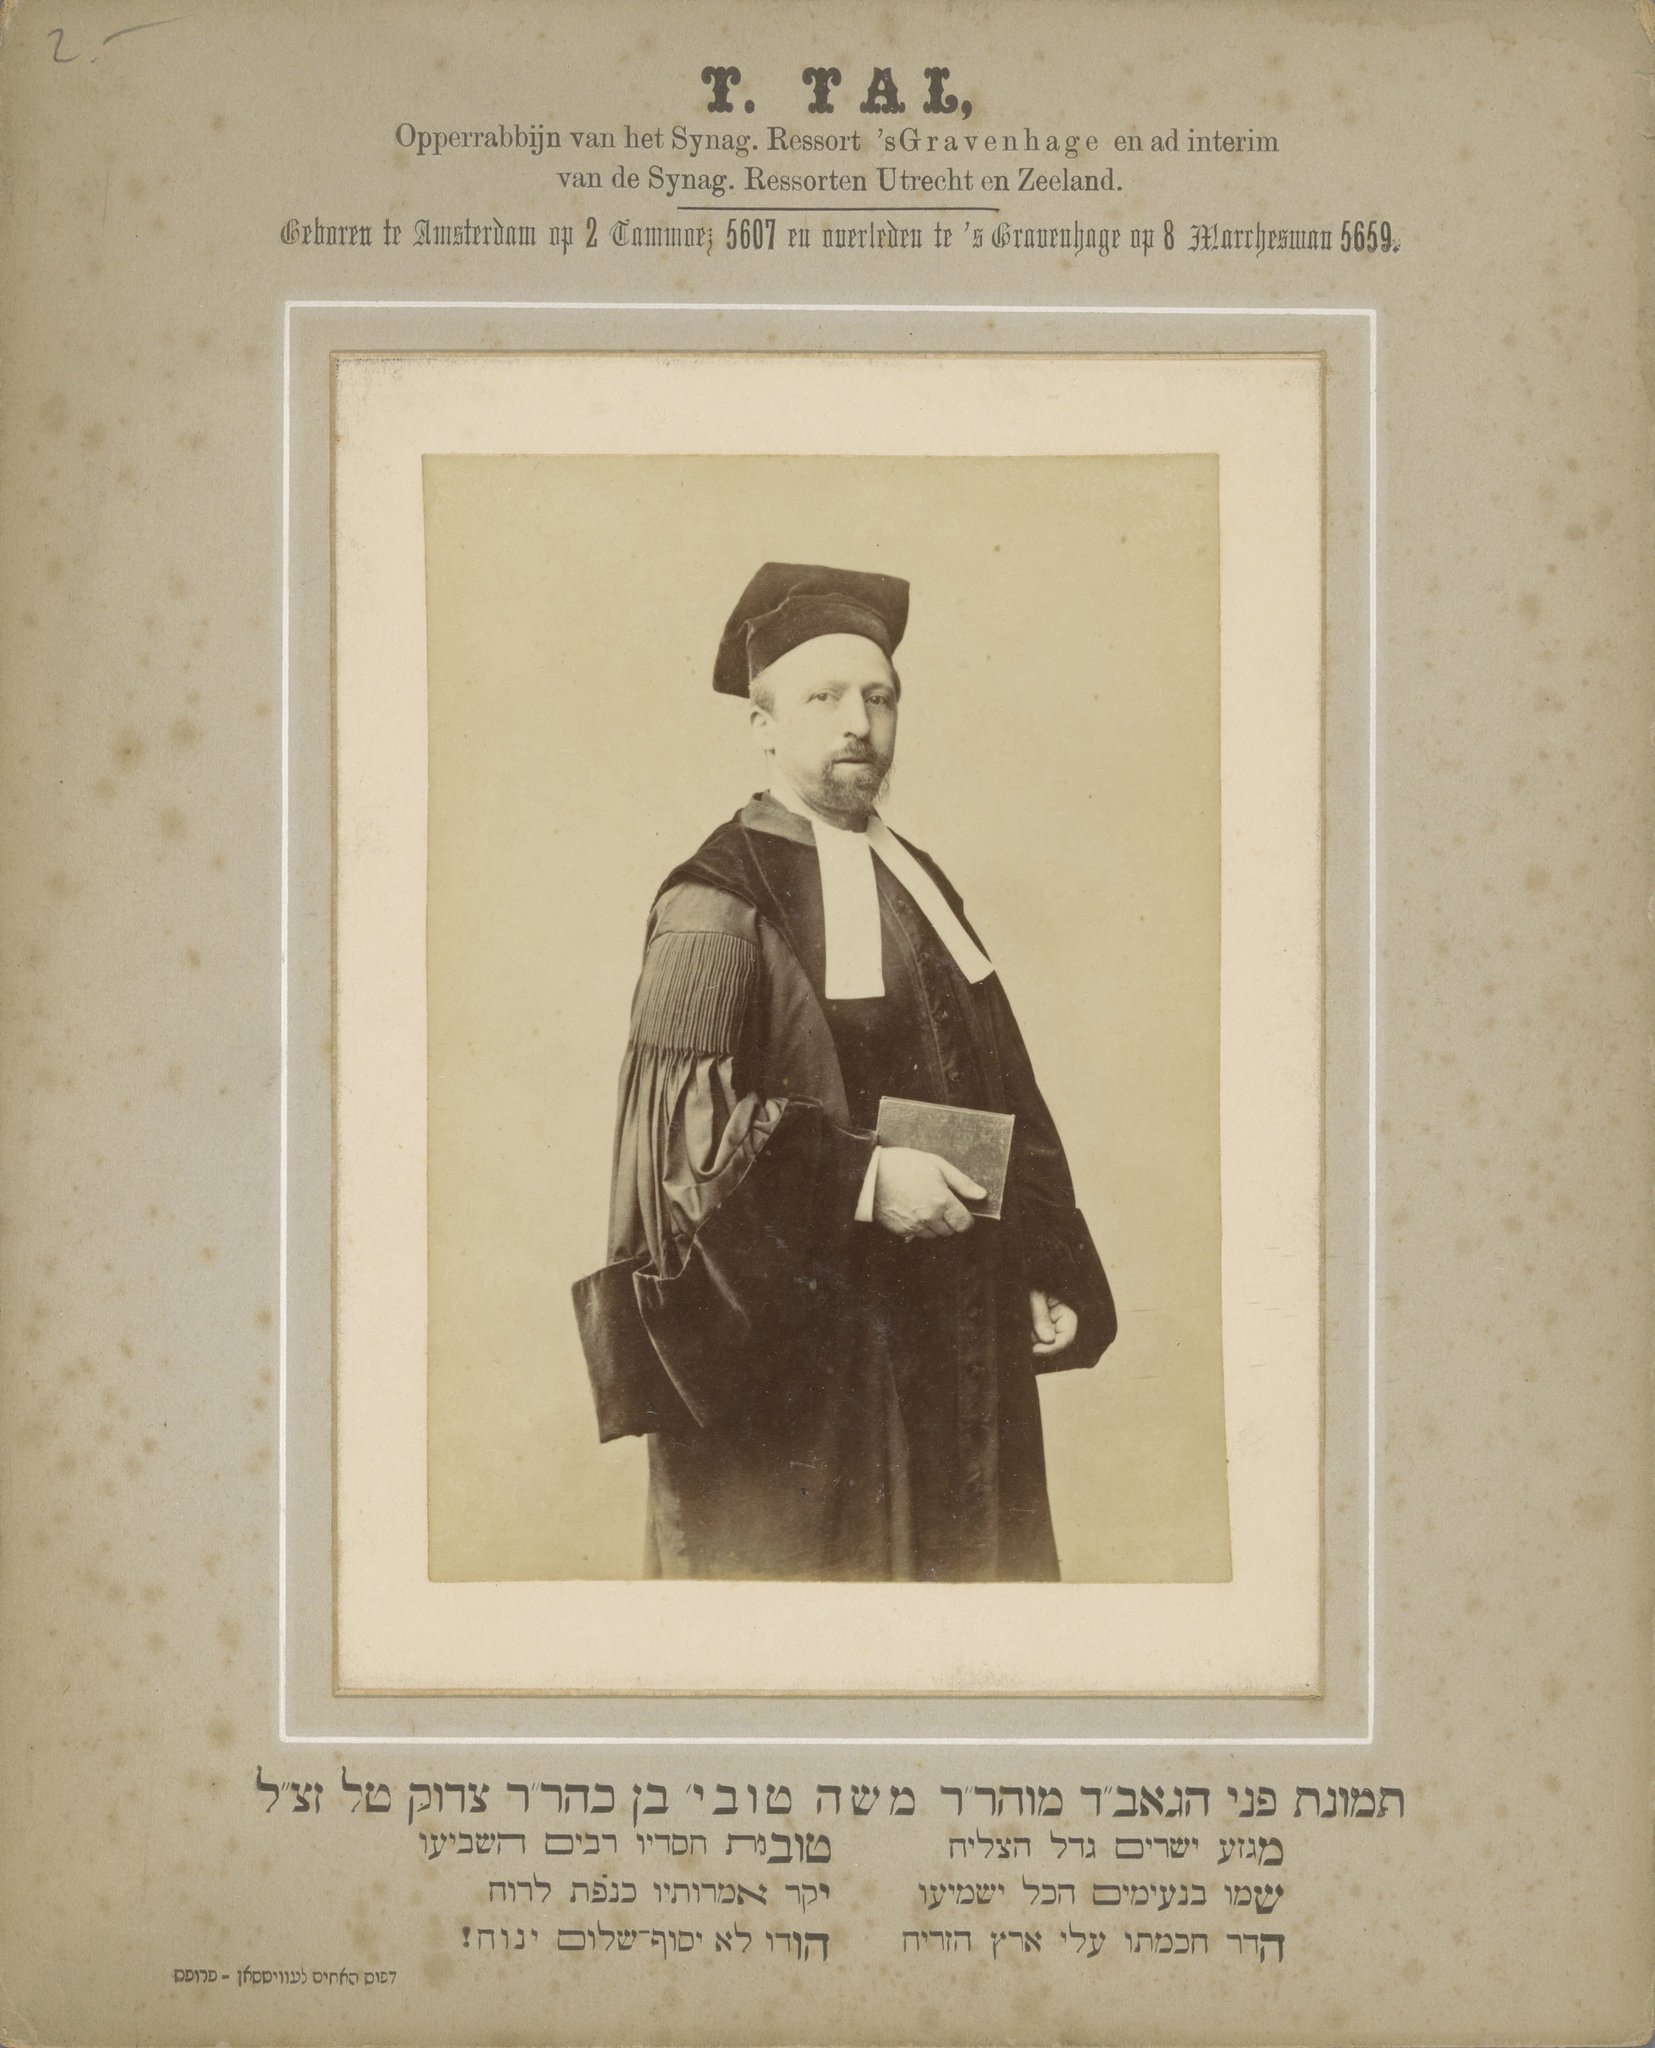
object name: photograph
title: Portret van Opperrabbijn T. Tal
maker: Anonymous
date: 1898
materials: cardboard, photographic support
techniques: albumen print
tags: historical persons, chief rabbi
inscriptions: inscription: ‘T. Tal oppperrabbijn van het Synag. Ressort 'ssGravenhage en ad interim van de Synag. Ressorten Utrecht en Zeeland...’